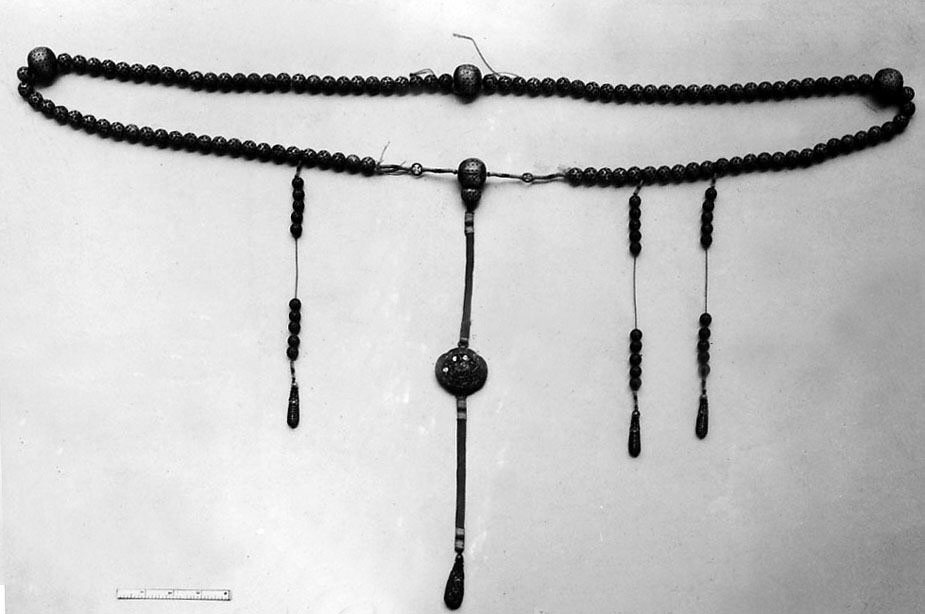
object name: necklace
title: Mandarin's Necklace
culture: chinese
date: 1801-1900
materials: enamel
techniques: painting